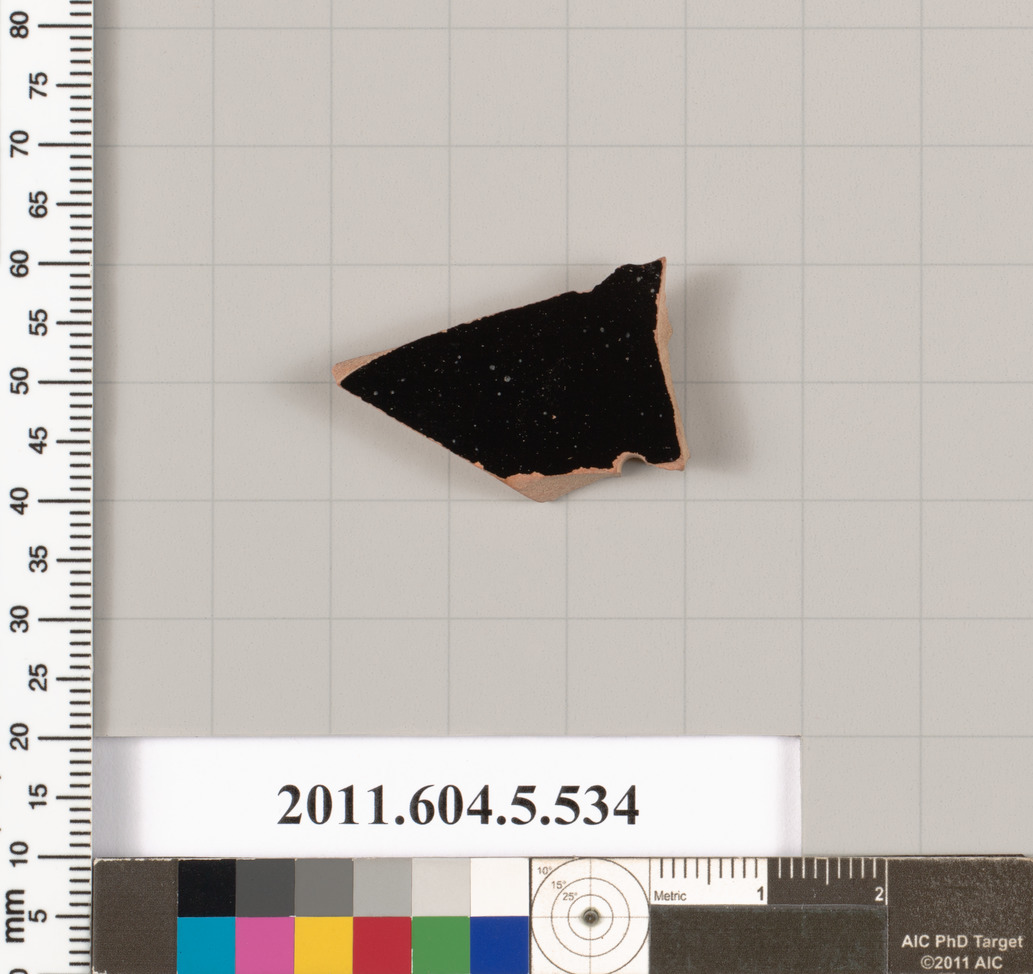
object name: kylix fragment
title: Terracotta fragment of a kylix (drinking cup)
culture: greek, attic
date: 600-401 BCE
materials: terracotta